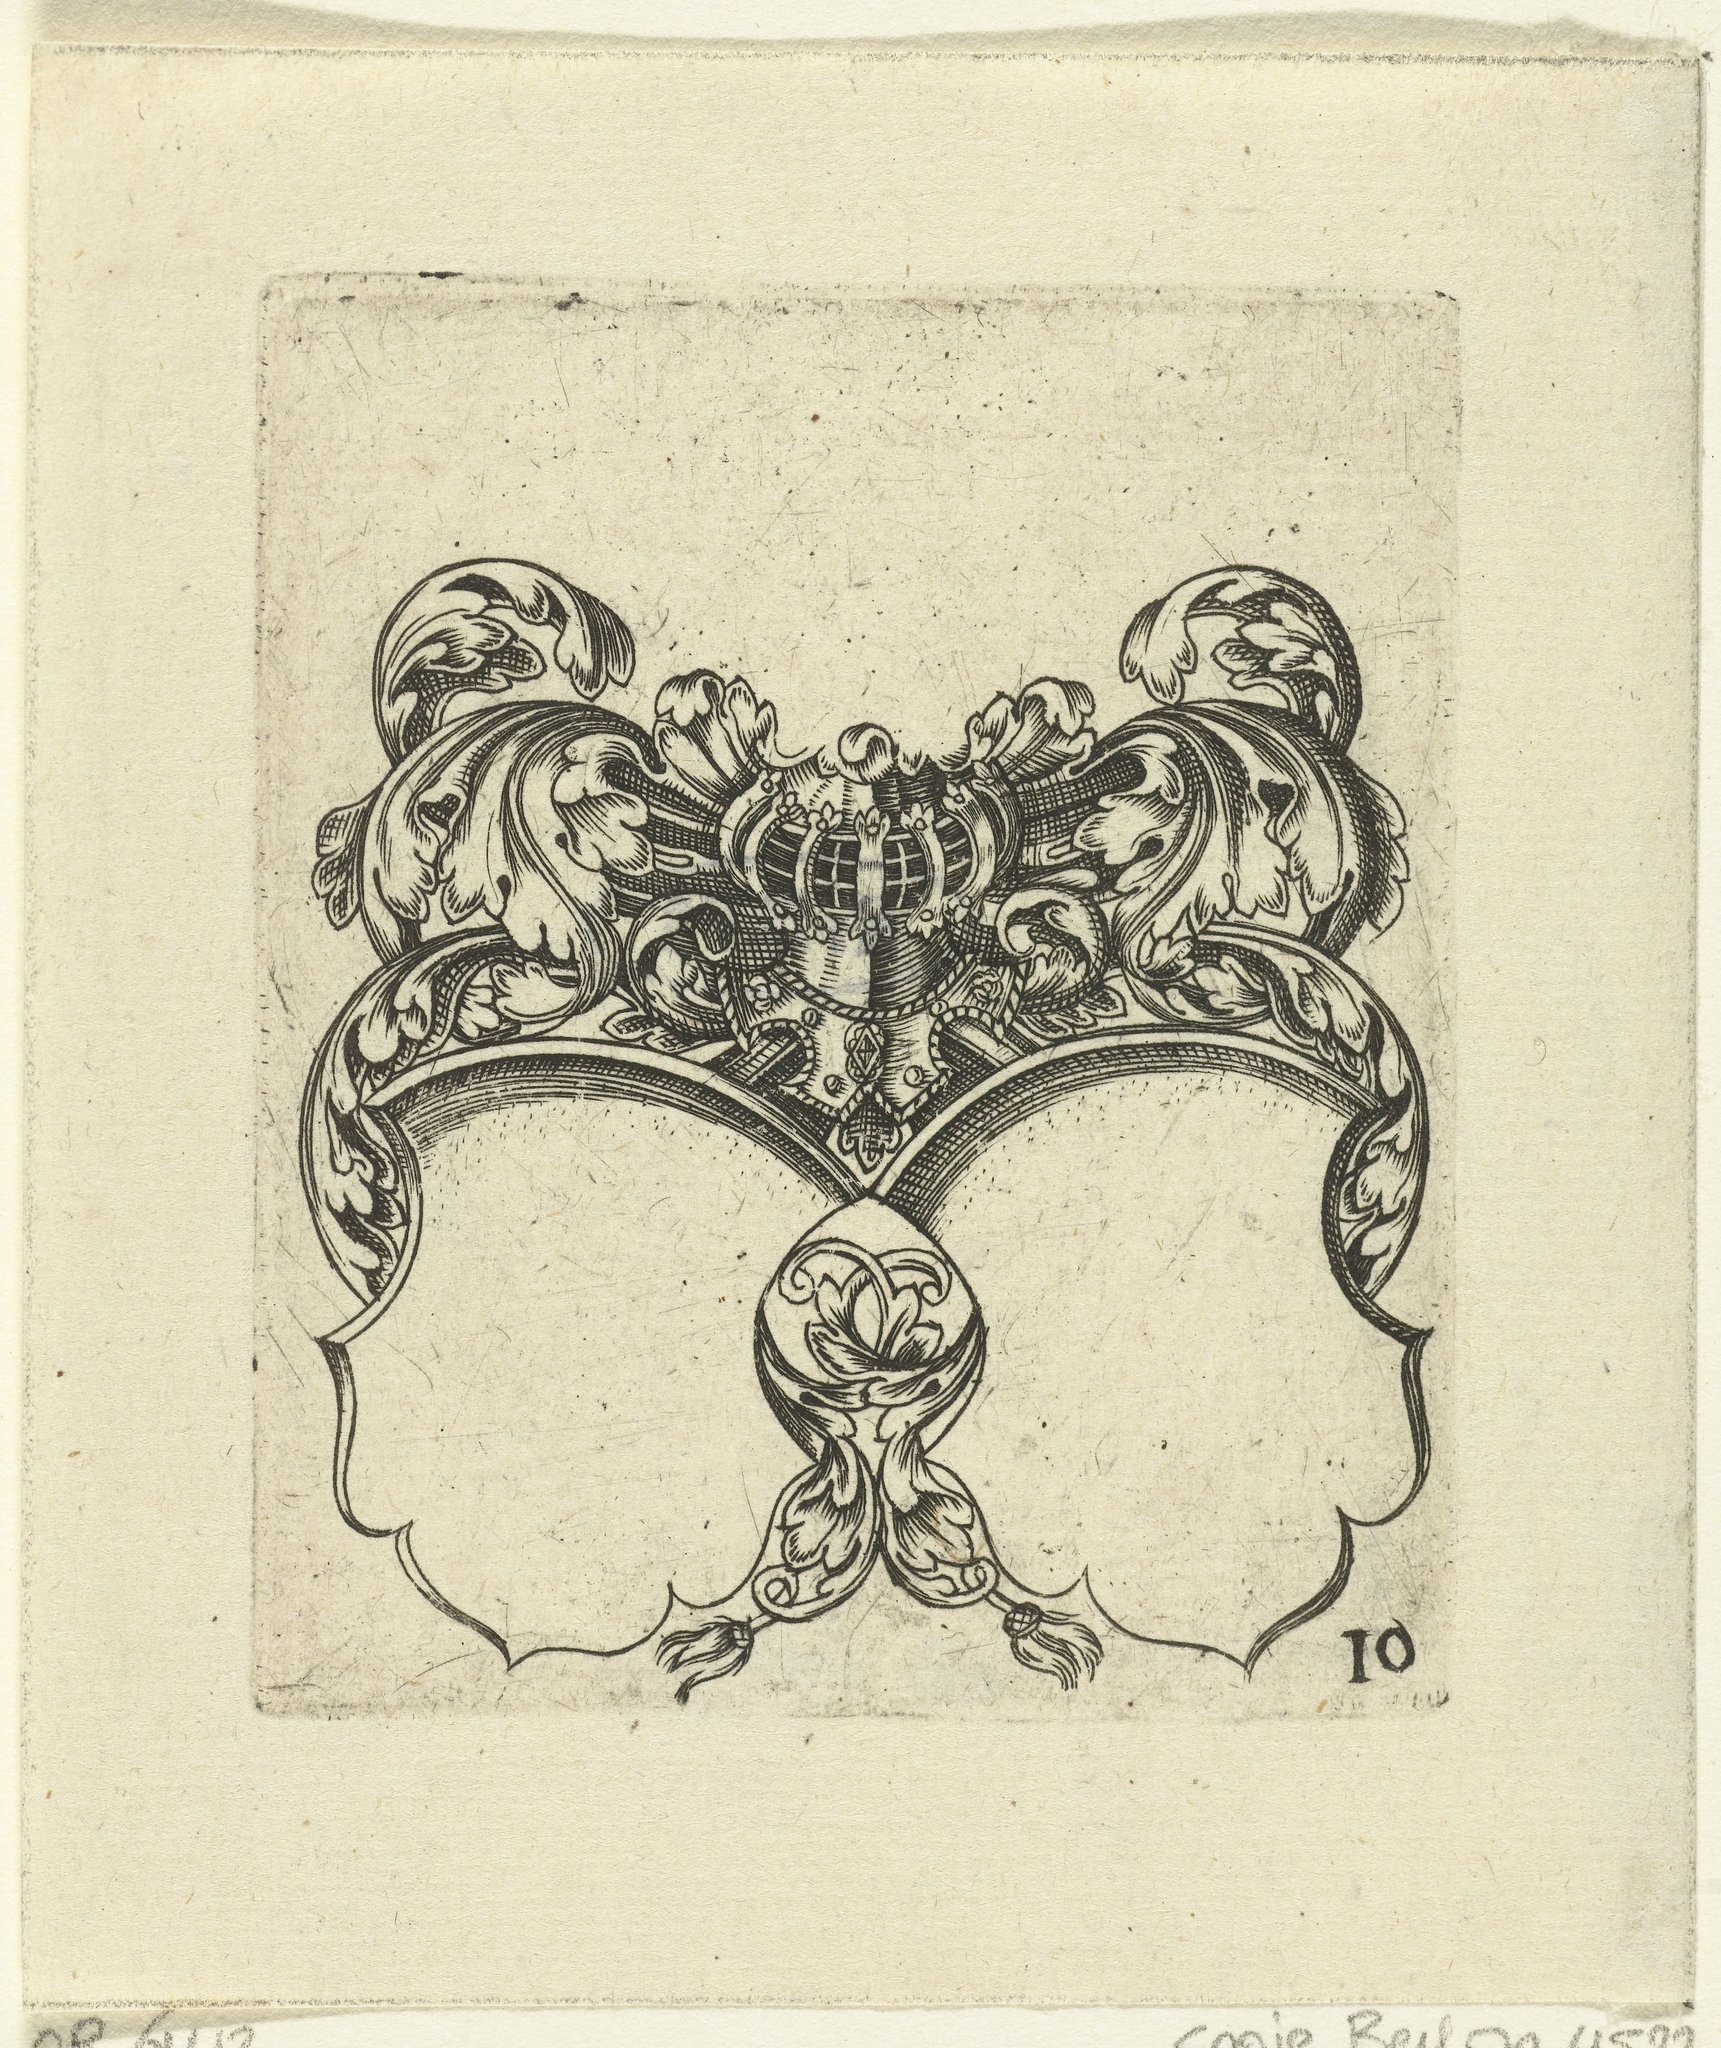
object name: print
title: Twee wapenschilden met helm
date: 1625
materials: paper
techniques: engraving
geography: amsterdam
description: Tegenzijdige kopie naar wapenschild van Theodor de Bry in het boek Emblemata Nobilitati.... Blad uit serie wapenschilden met lege compartimenten.